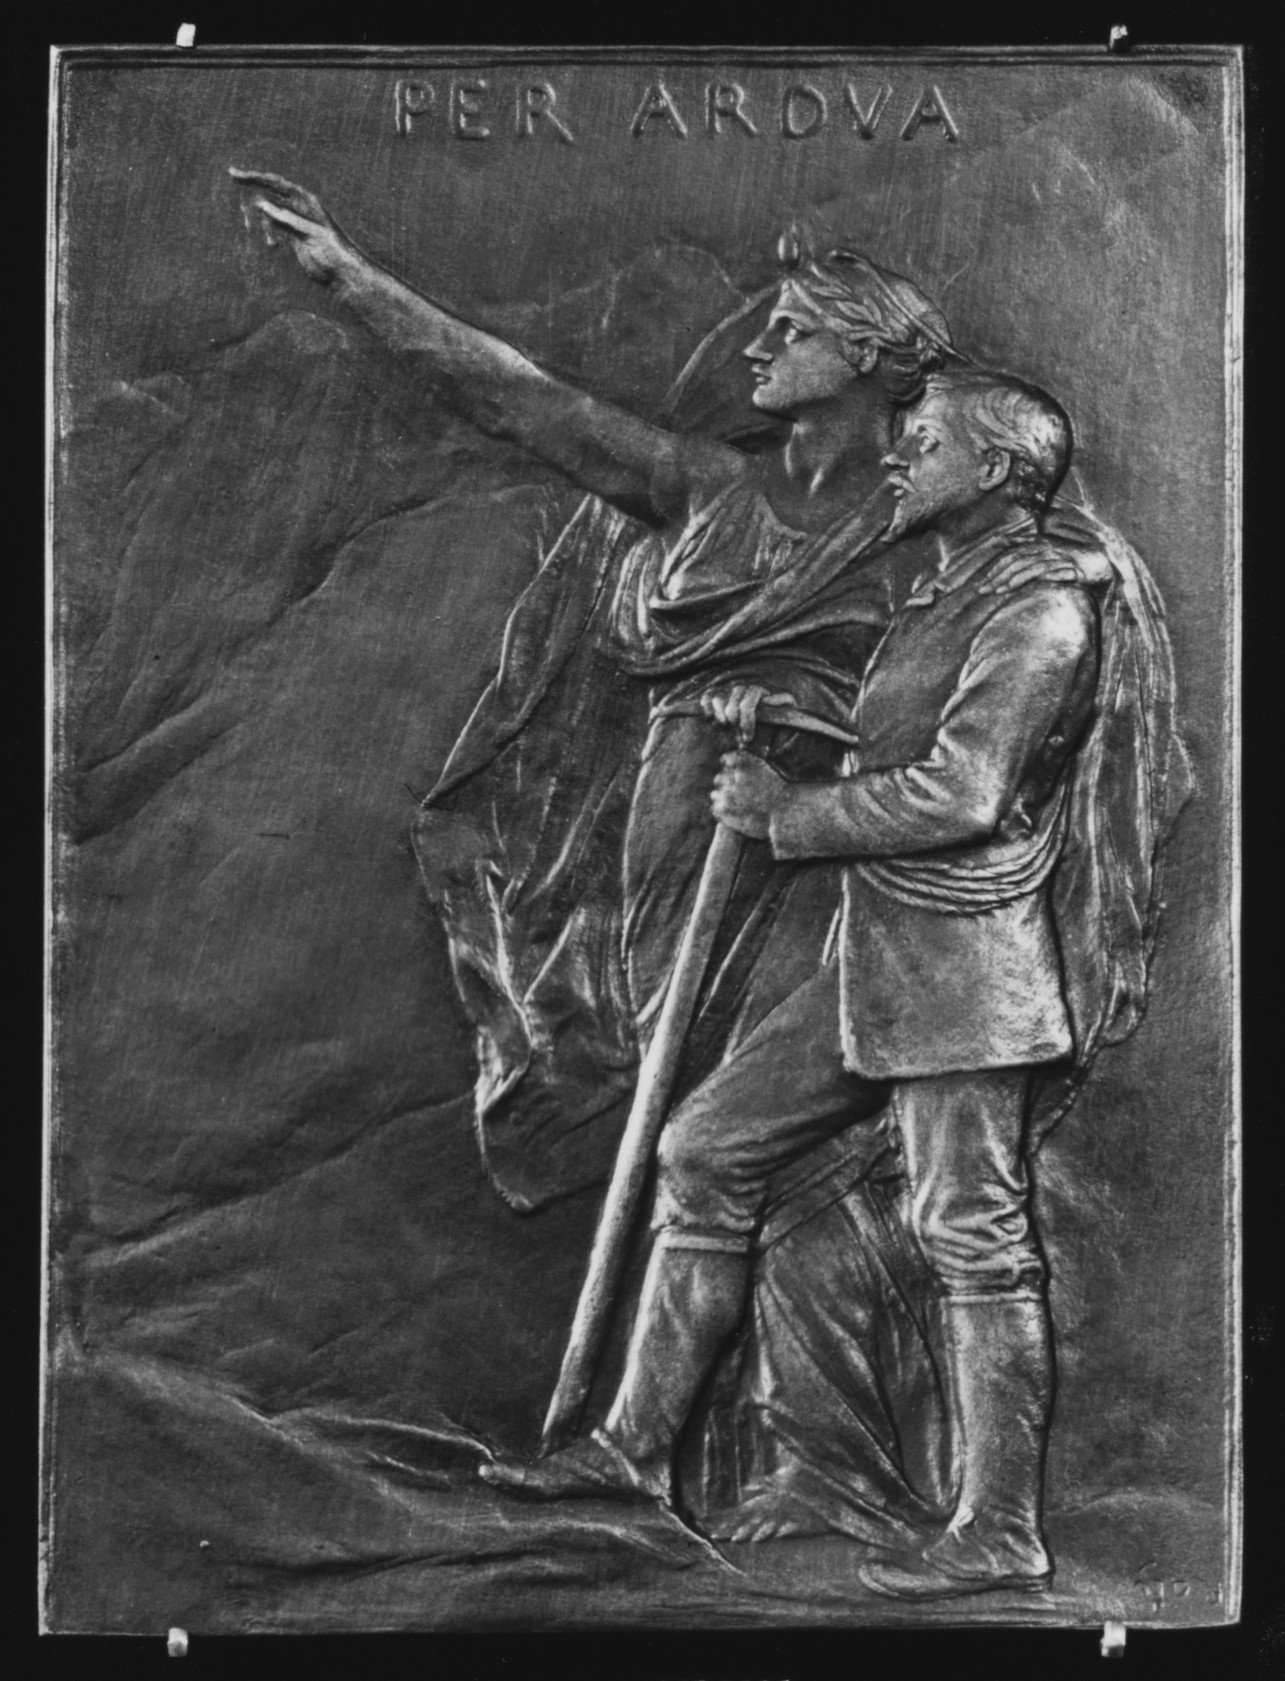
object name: plaquette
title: For the French Alpine Club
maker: louis-oscar roty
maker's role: artist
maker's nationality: french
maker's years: 1846-1911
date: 1889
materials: bronze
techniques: silvered, struck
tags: men,mountains